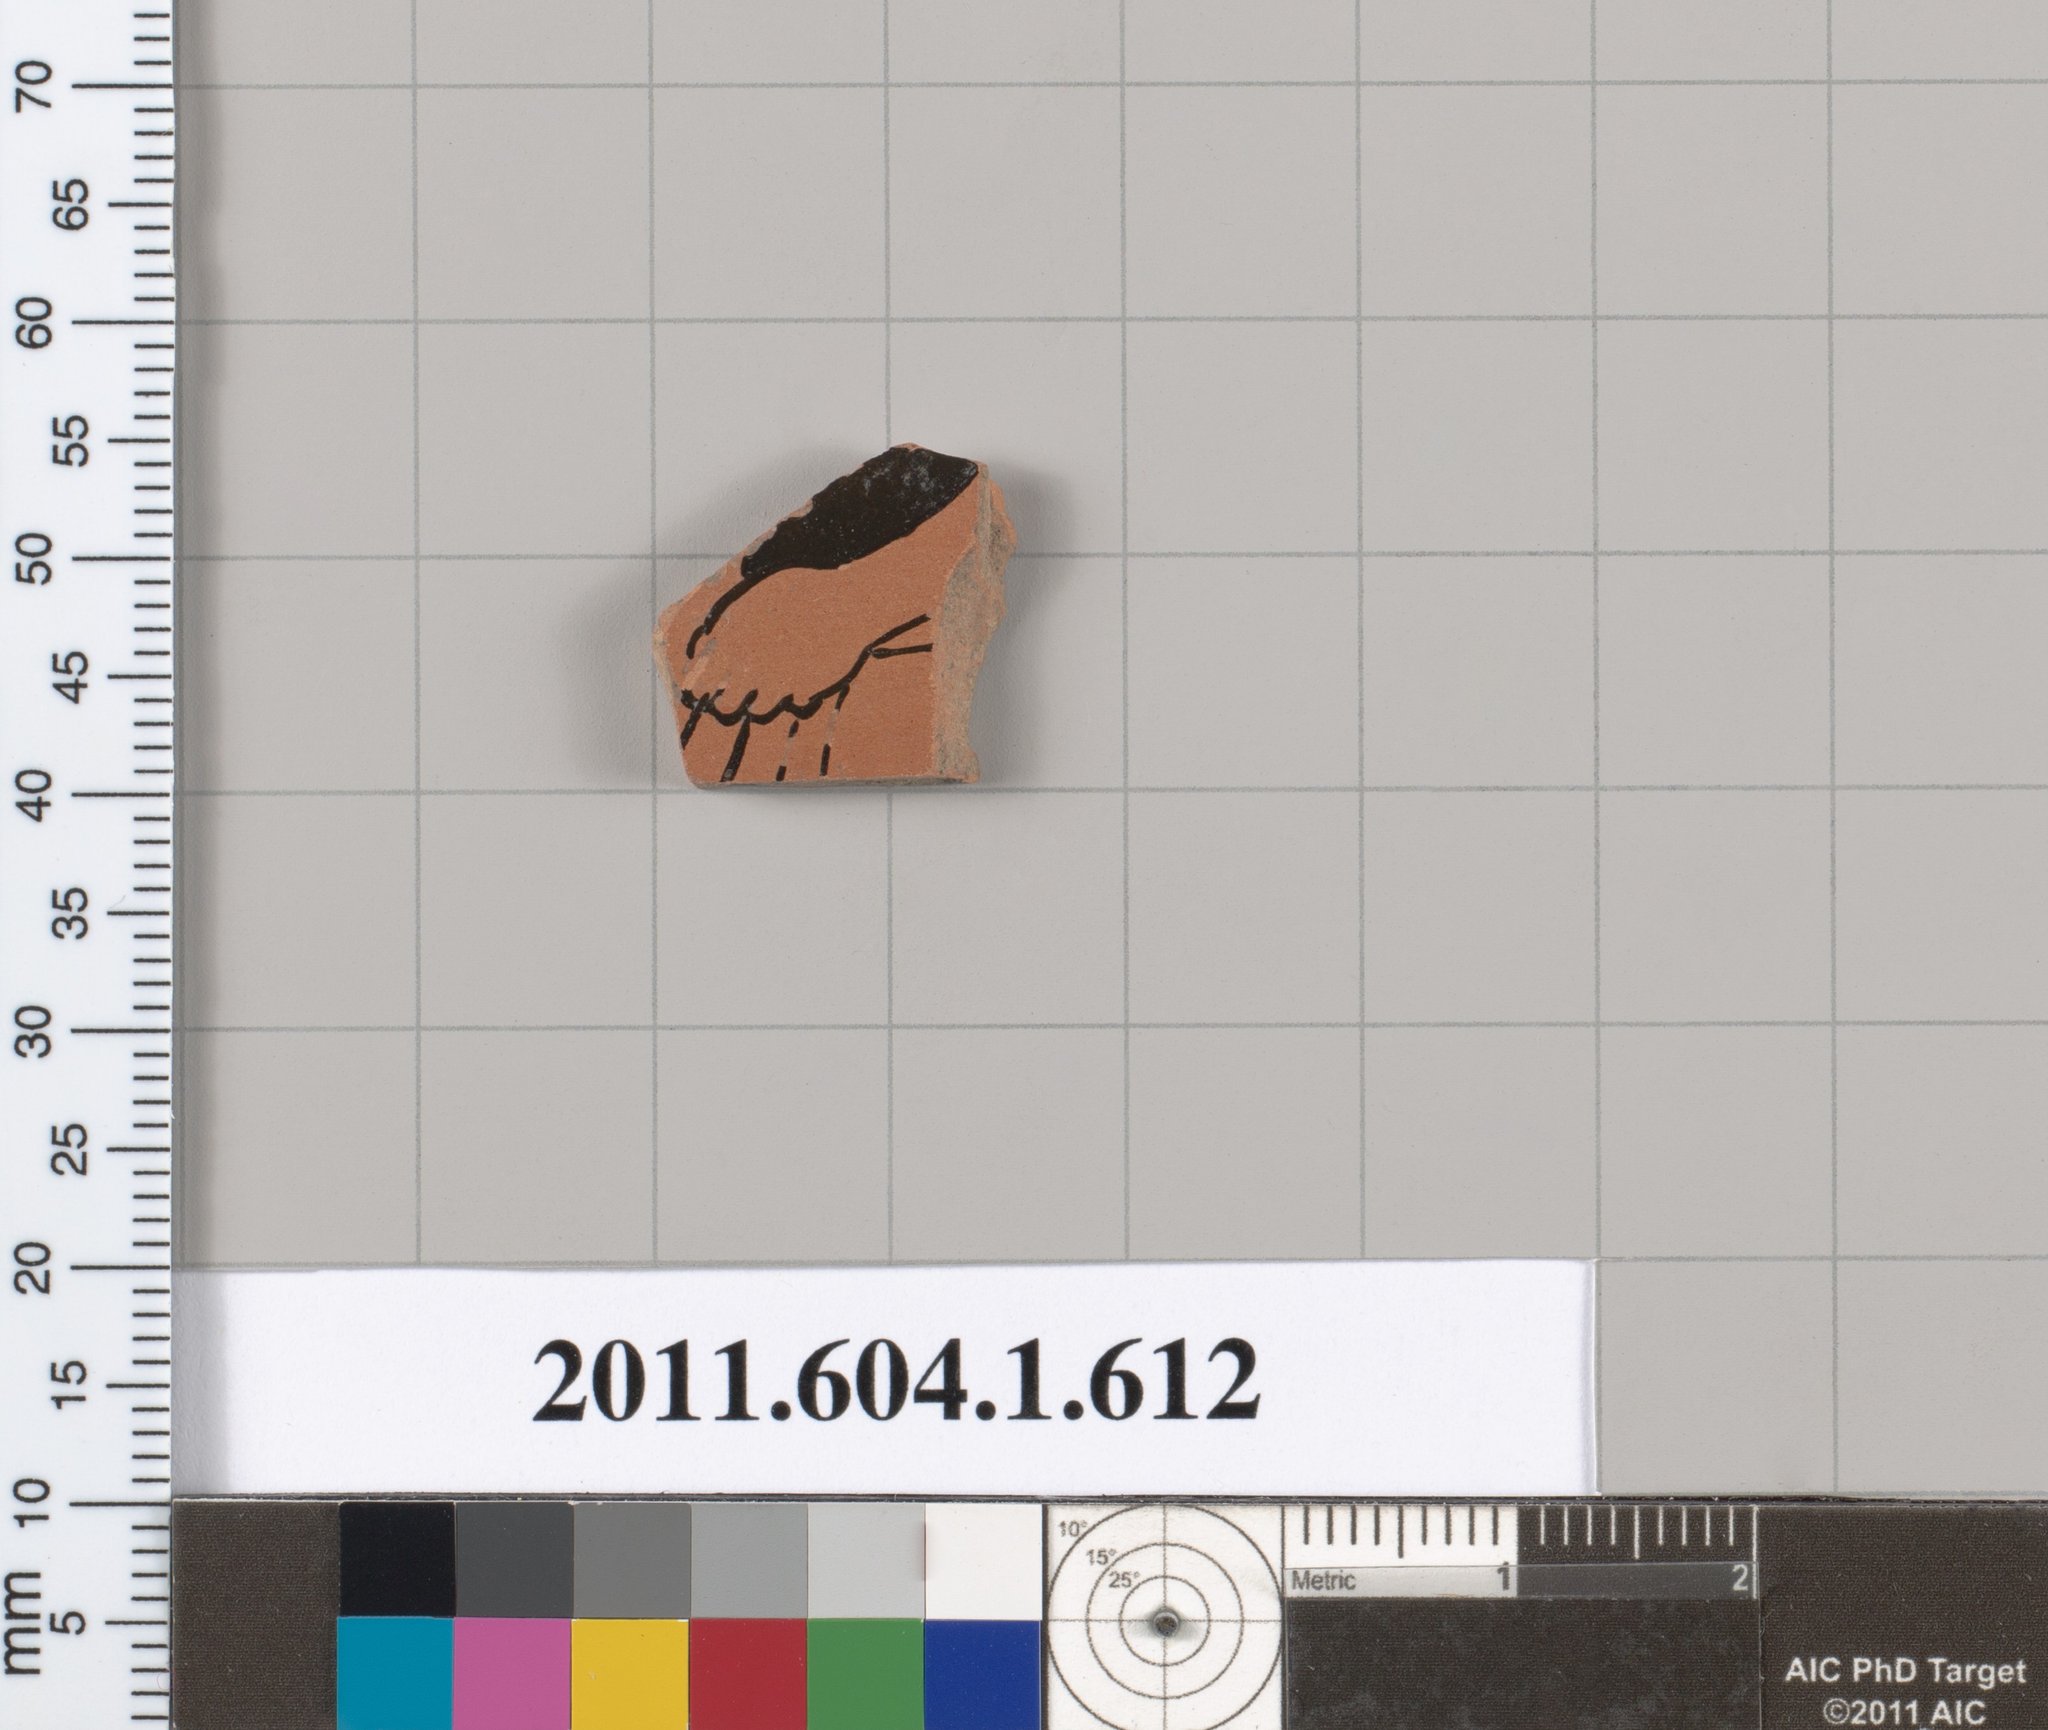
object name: kylix fragment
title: Terracotta fragment of a kylix (drinking cup)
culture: greek, attic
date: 475-451 BCE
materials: terracotta